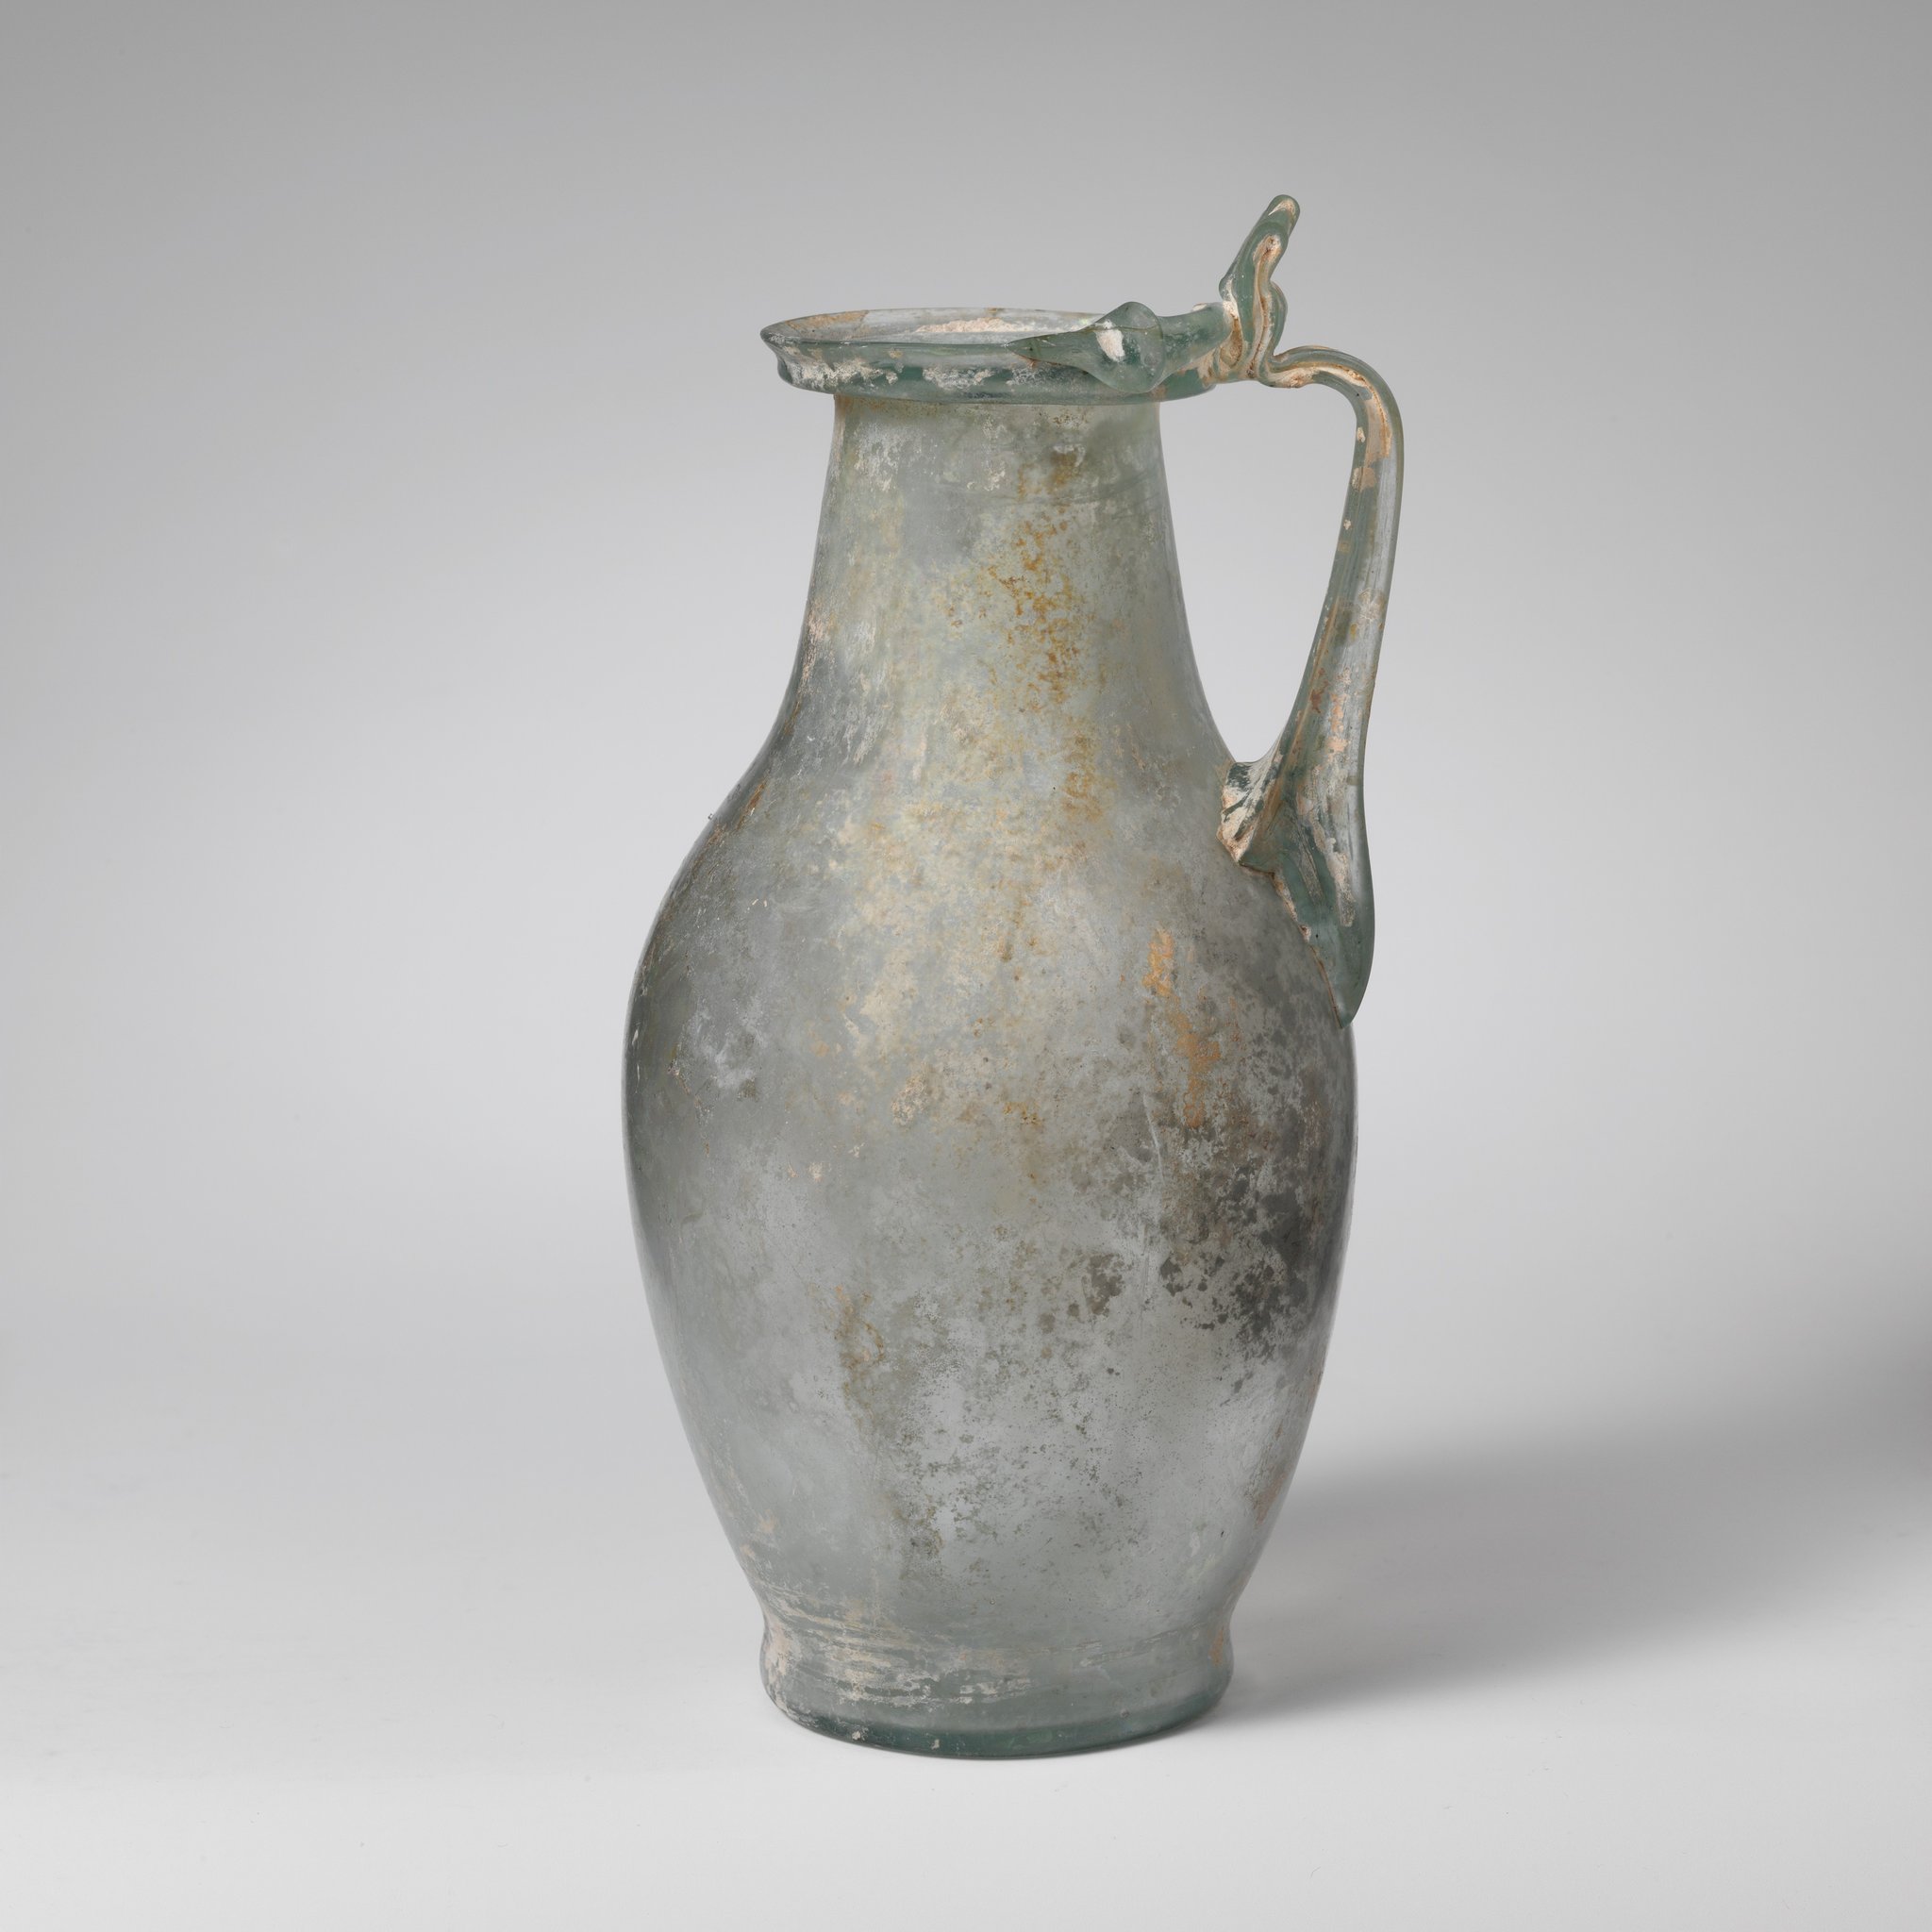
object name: jug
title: Glass jug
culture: roman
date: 34-200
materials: glass